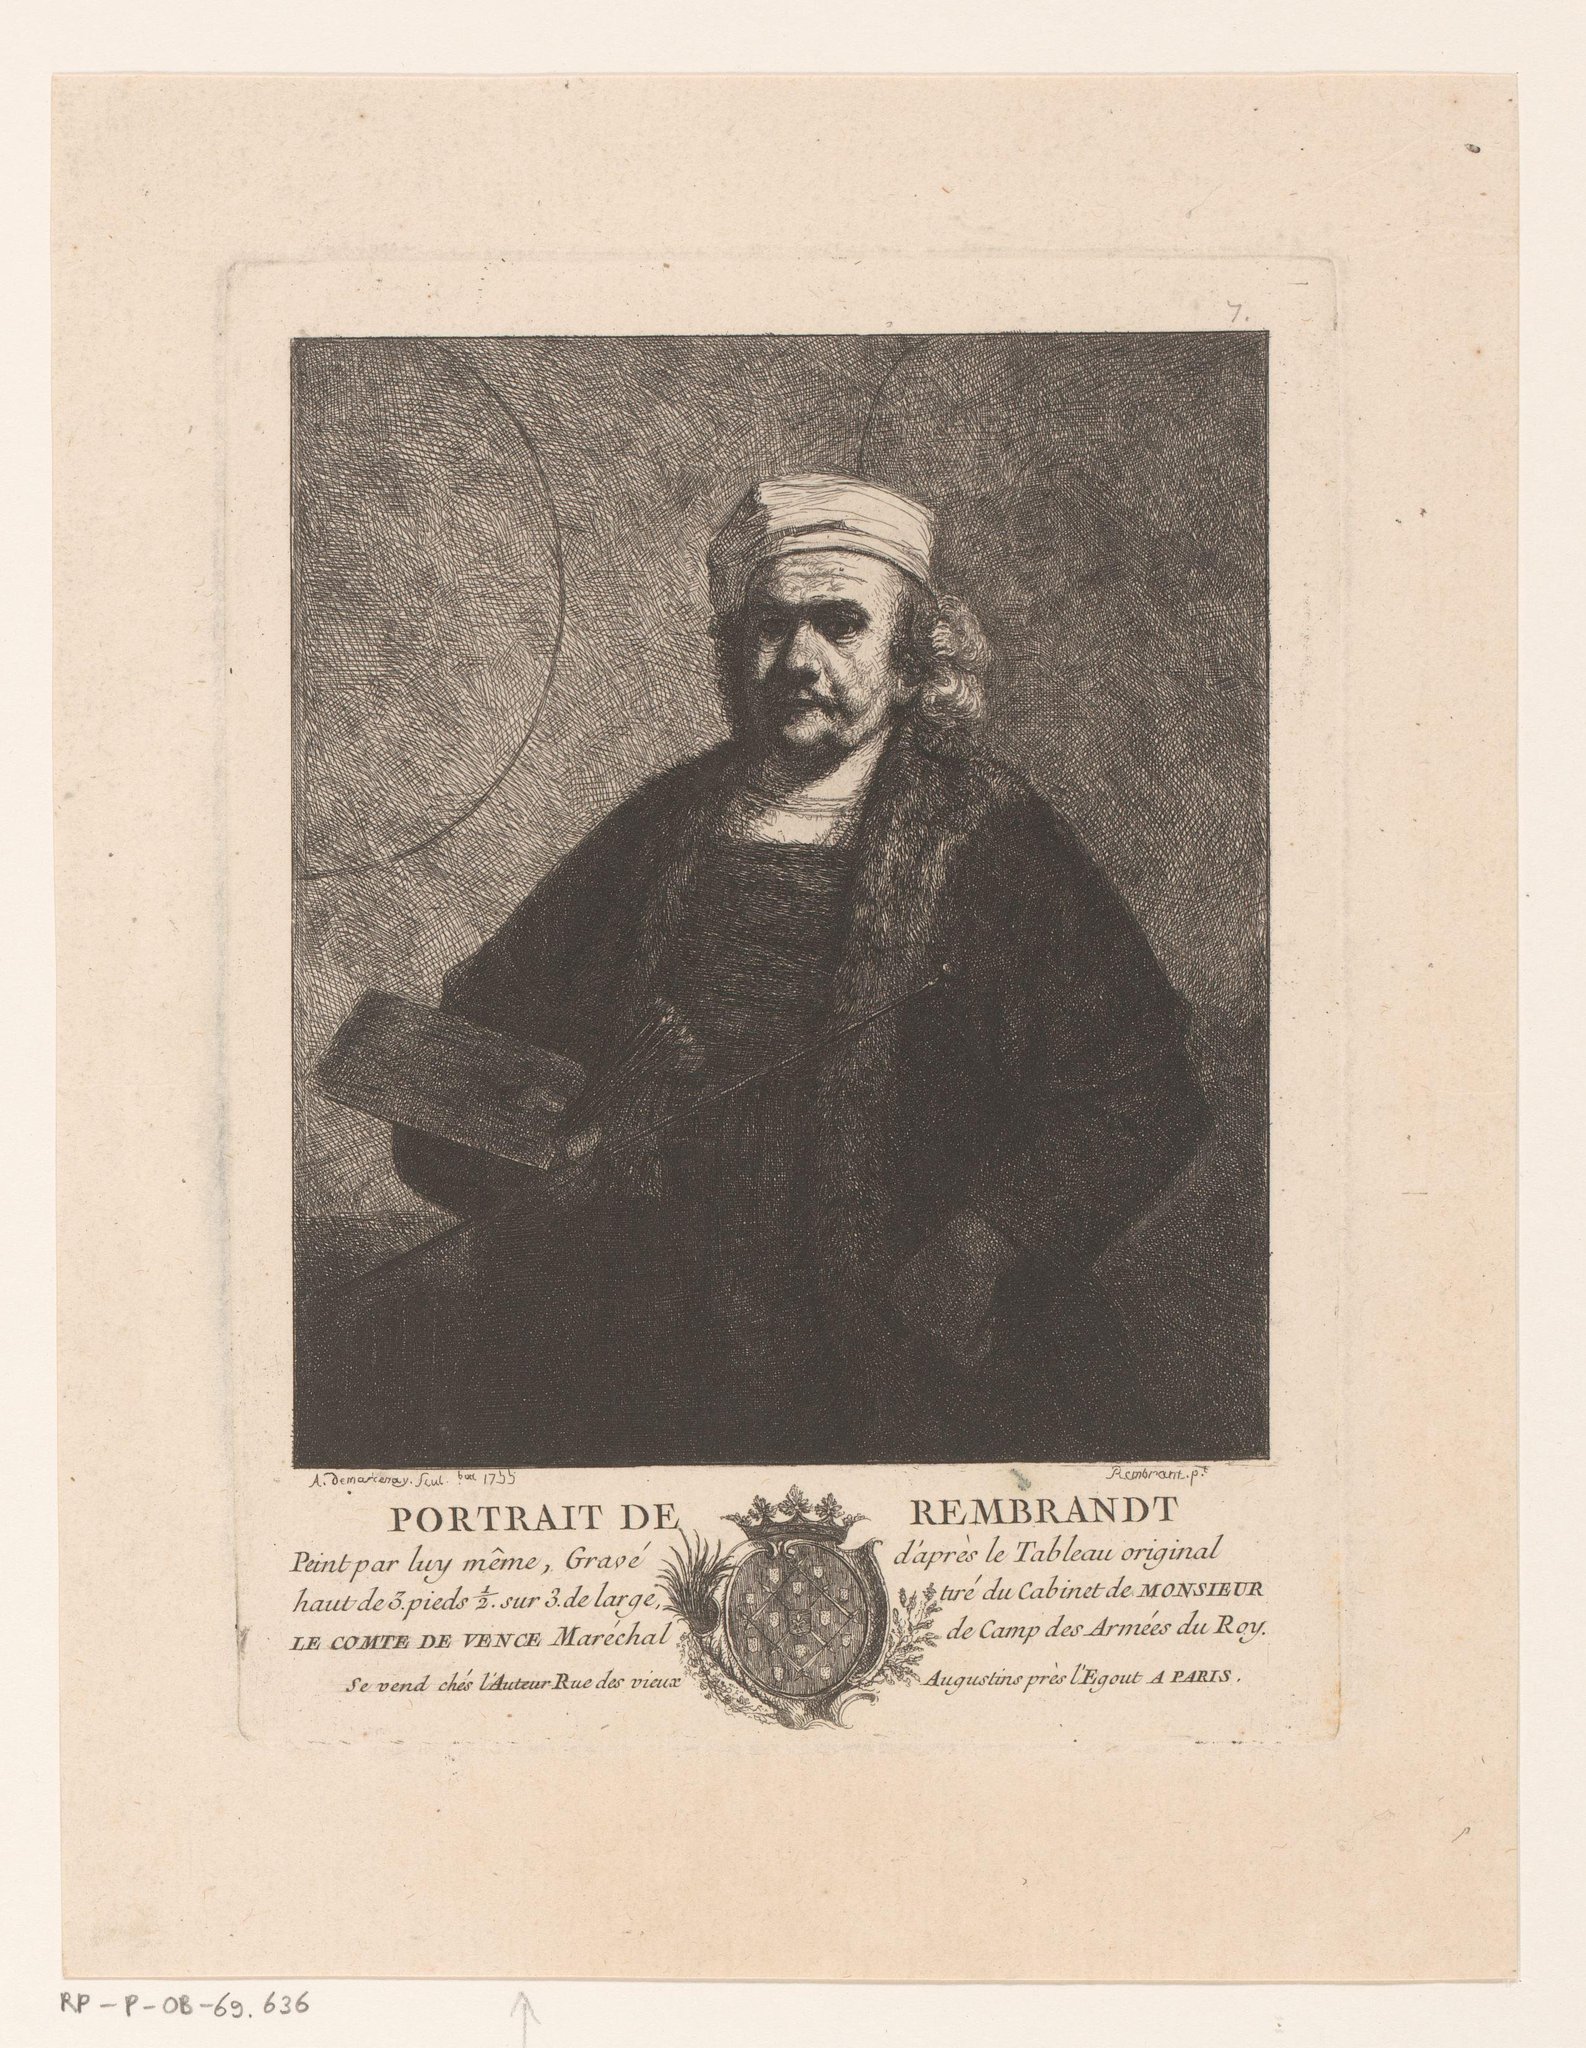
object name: print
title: Portrait de Rembrandt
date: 1755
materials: paper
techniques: etching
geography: paris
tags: leiden, amsterdam, painter, print maker, draughtsman, rembrandt van rijn, historical persons, portrait, self-portrait of artist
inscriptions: collector's mark: Lugt 240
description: Het schilderij door Rembrandt bevindt zich in de collectie van Kenwood House, Hampstead (Londen), inv.nr. 57, bequest of the earl of Iveagh.